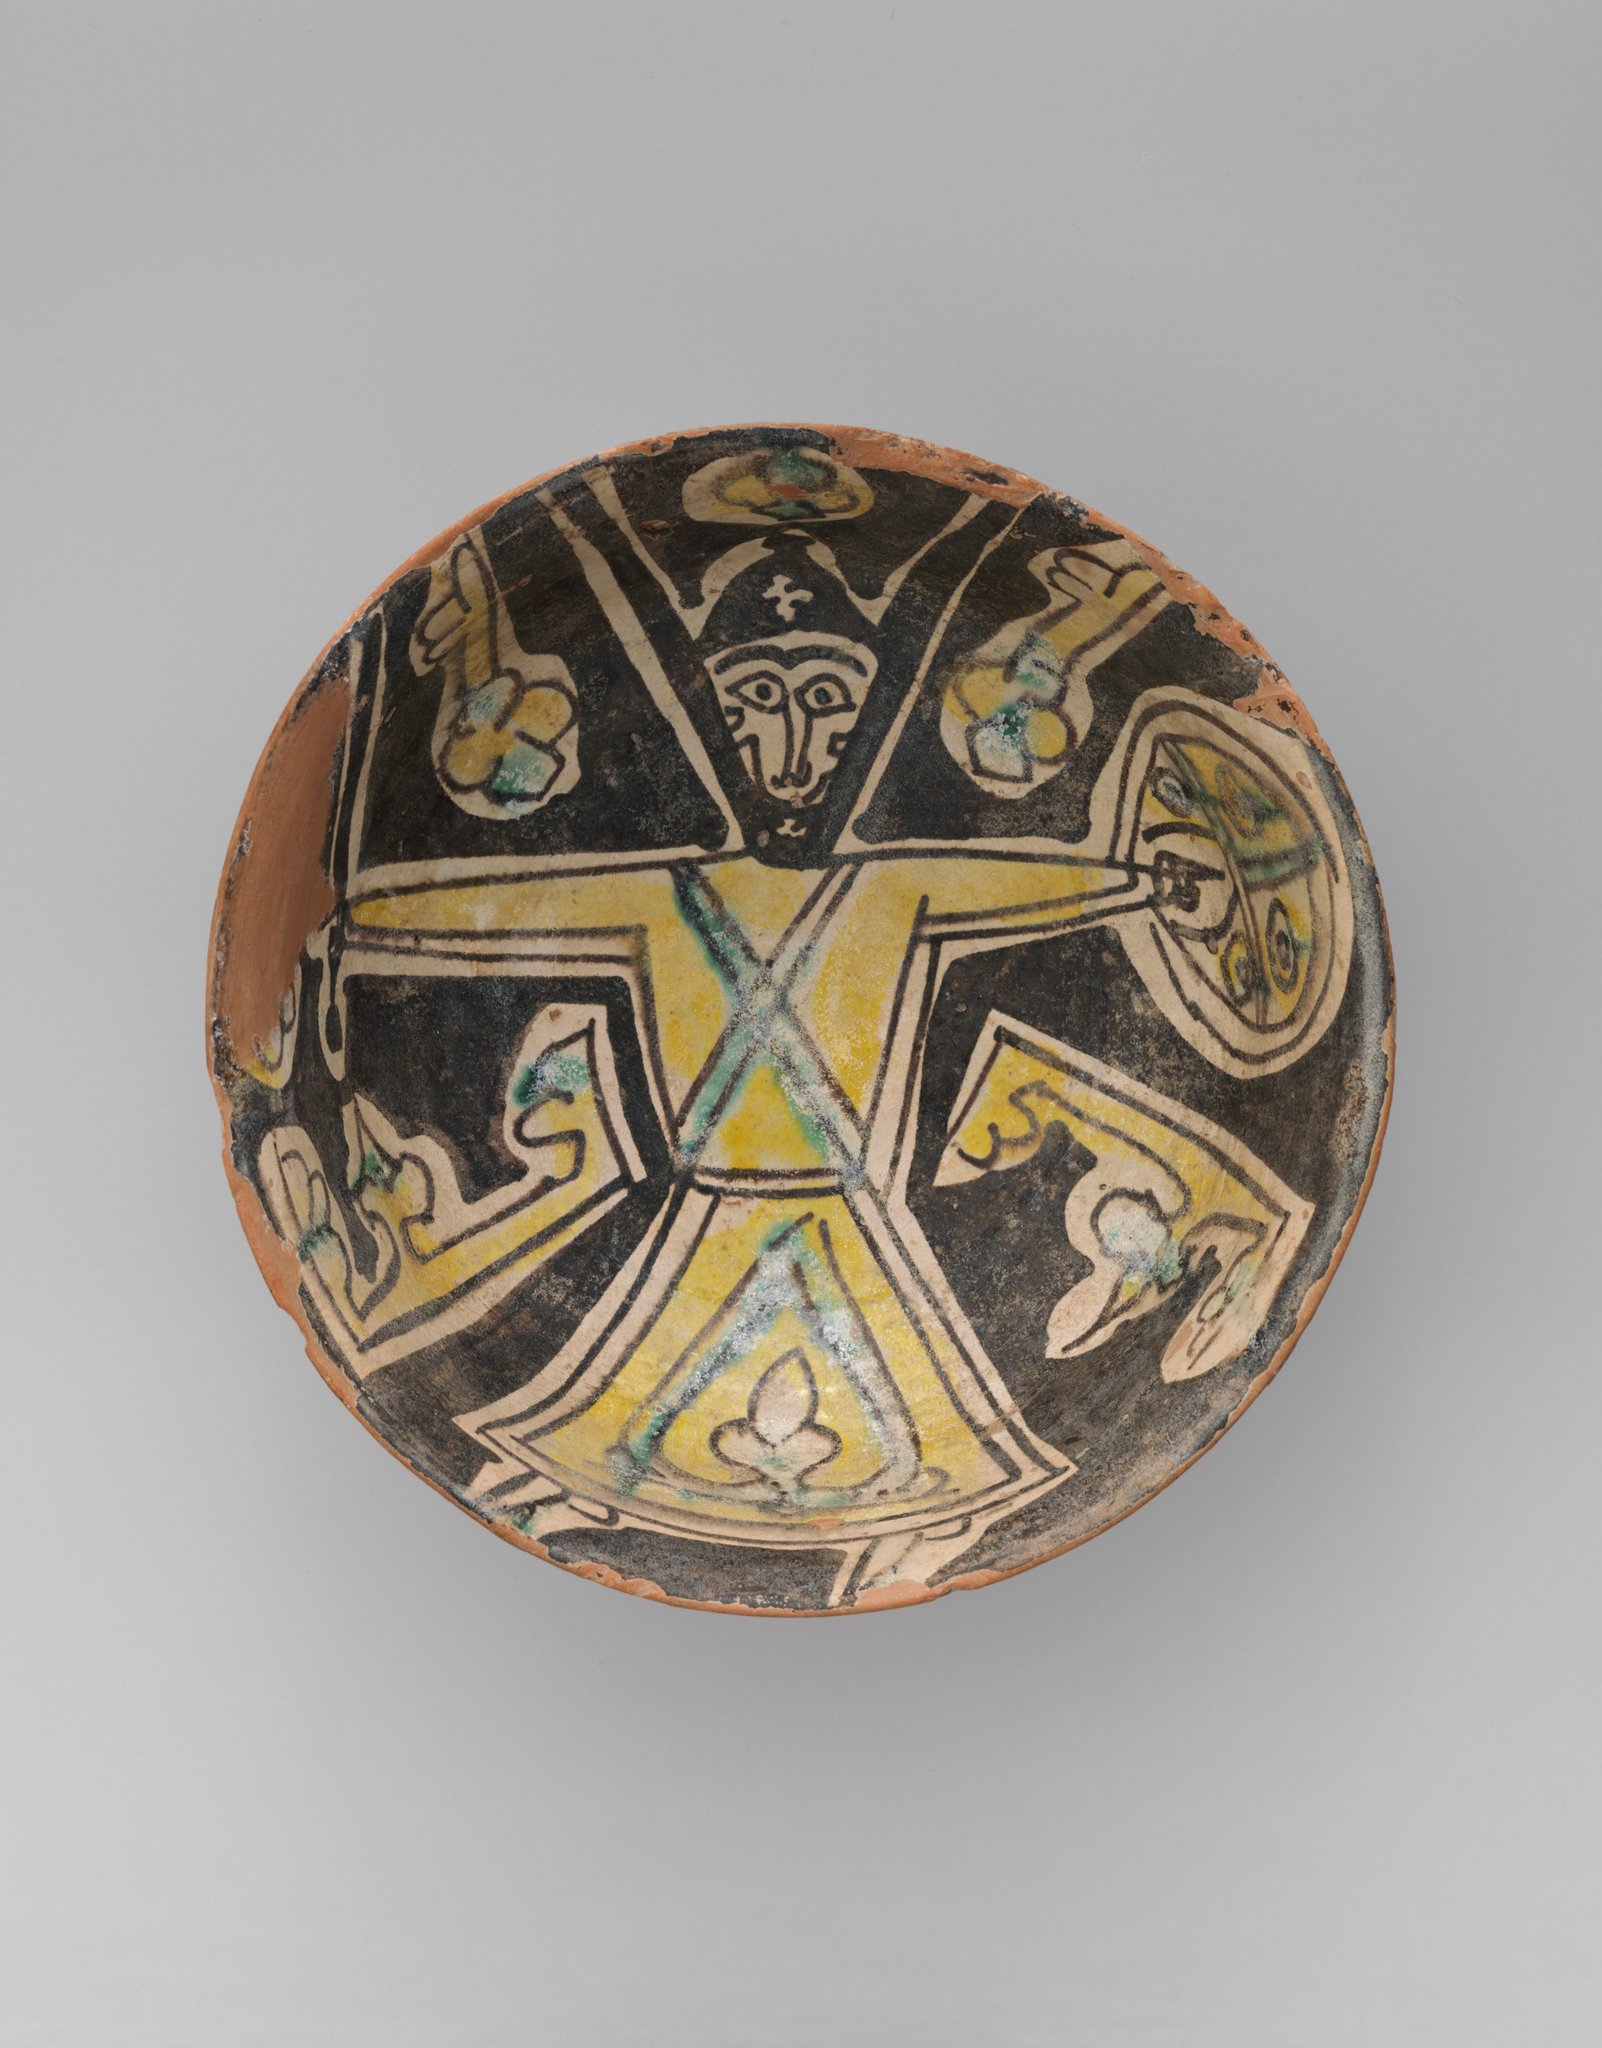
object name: bowl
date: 901-1000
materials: earthenware, glaze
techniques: polychrome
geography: uzbekistan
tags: soldiers,men